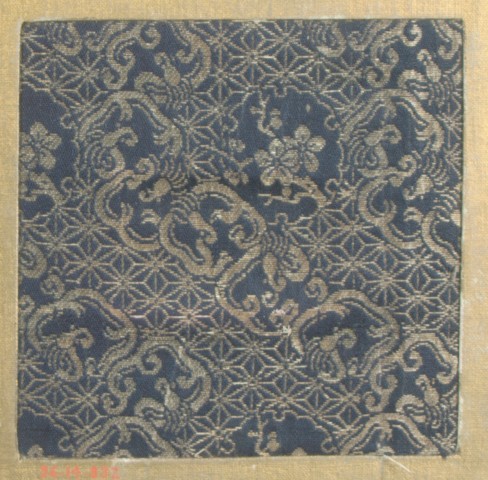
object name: piece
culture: japanese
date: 1701-1900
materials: metal thread, silk